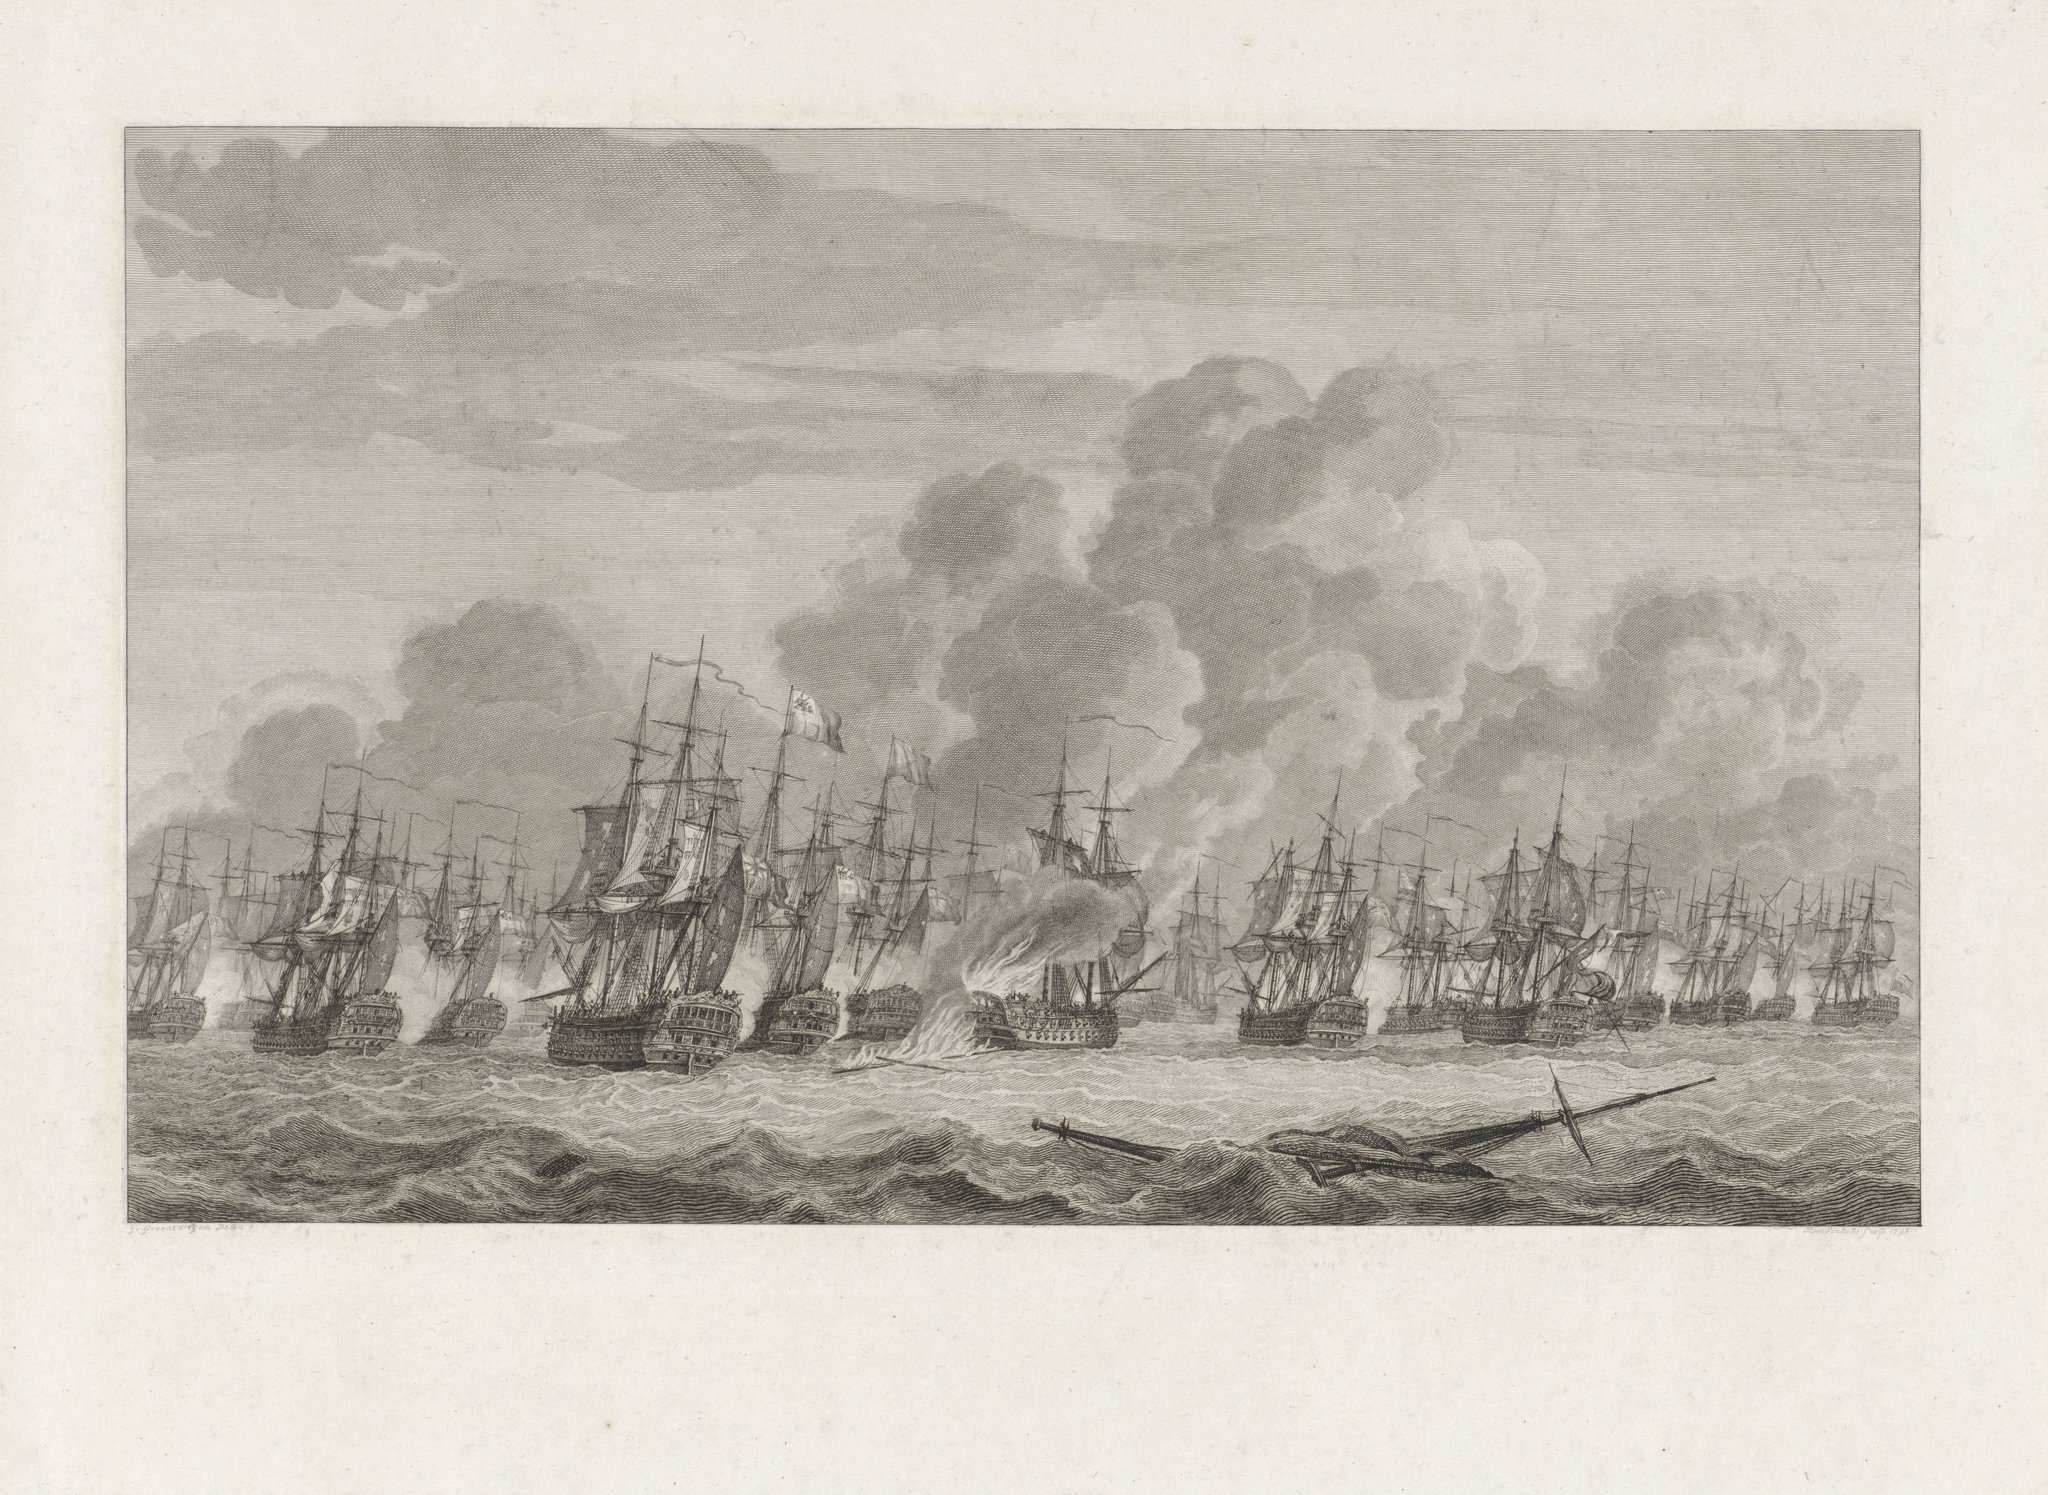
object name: print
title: Zeeslag bij Kamperduin (midden), 1797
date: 1798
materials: paper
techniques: engraving, etching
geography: amsterdam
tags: battle (+ naval force), battle of camperdown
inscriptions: collector's mark: Lugt 240, collector's mark: Lugt 2228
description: De Zeeslag bij Kamperduin op 11 oktober 1797 tussen de Bataafse vloot onder bevel van viceadmiraal Jan Willem de Winter en een Britse vloot onder admiraal Adam Duncan. Midden van de slag. Centraal de Vrijheid (dit schip onder bevel van De Winter) en de Hercules die zijn brandende bezaansmast kapt; rechts de Engelse vloot.